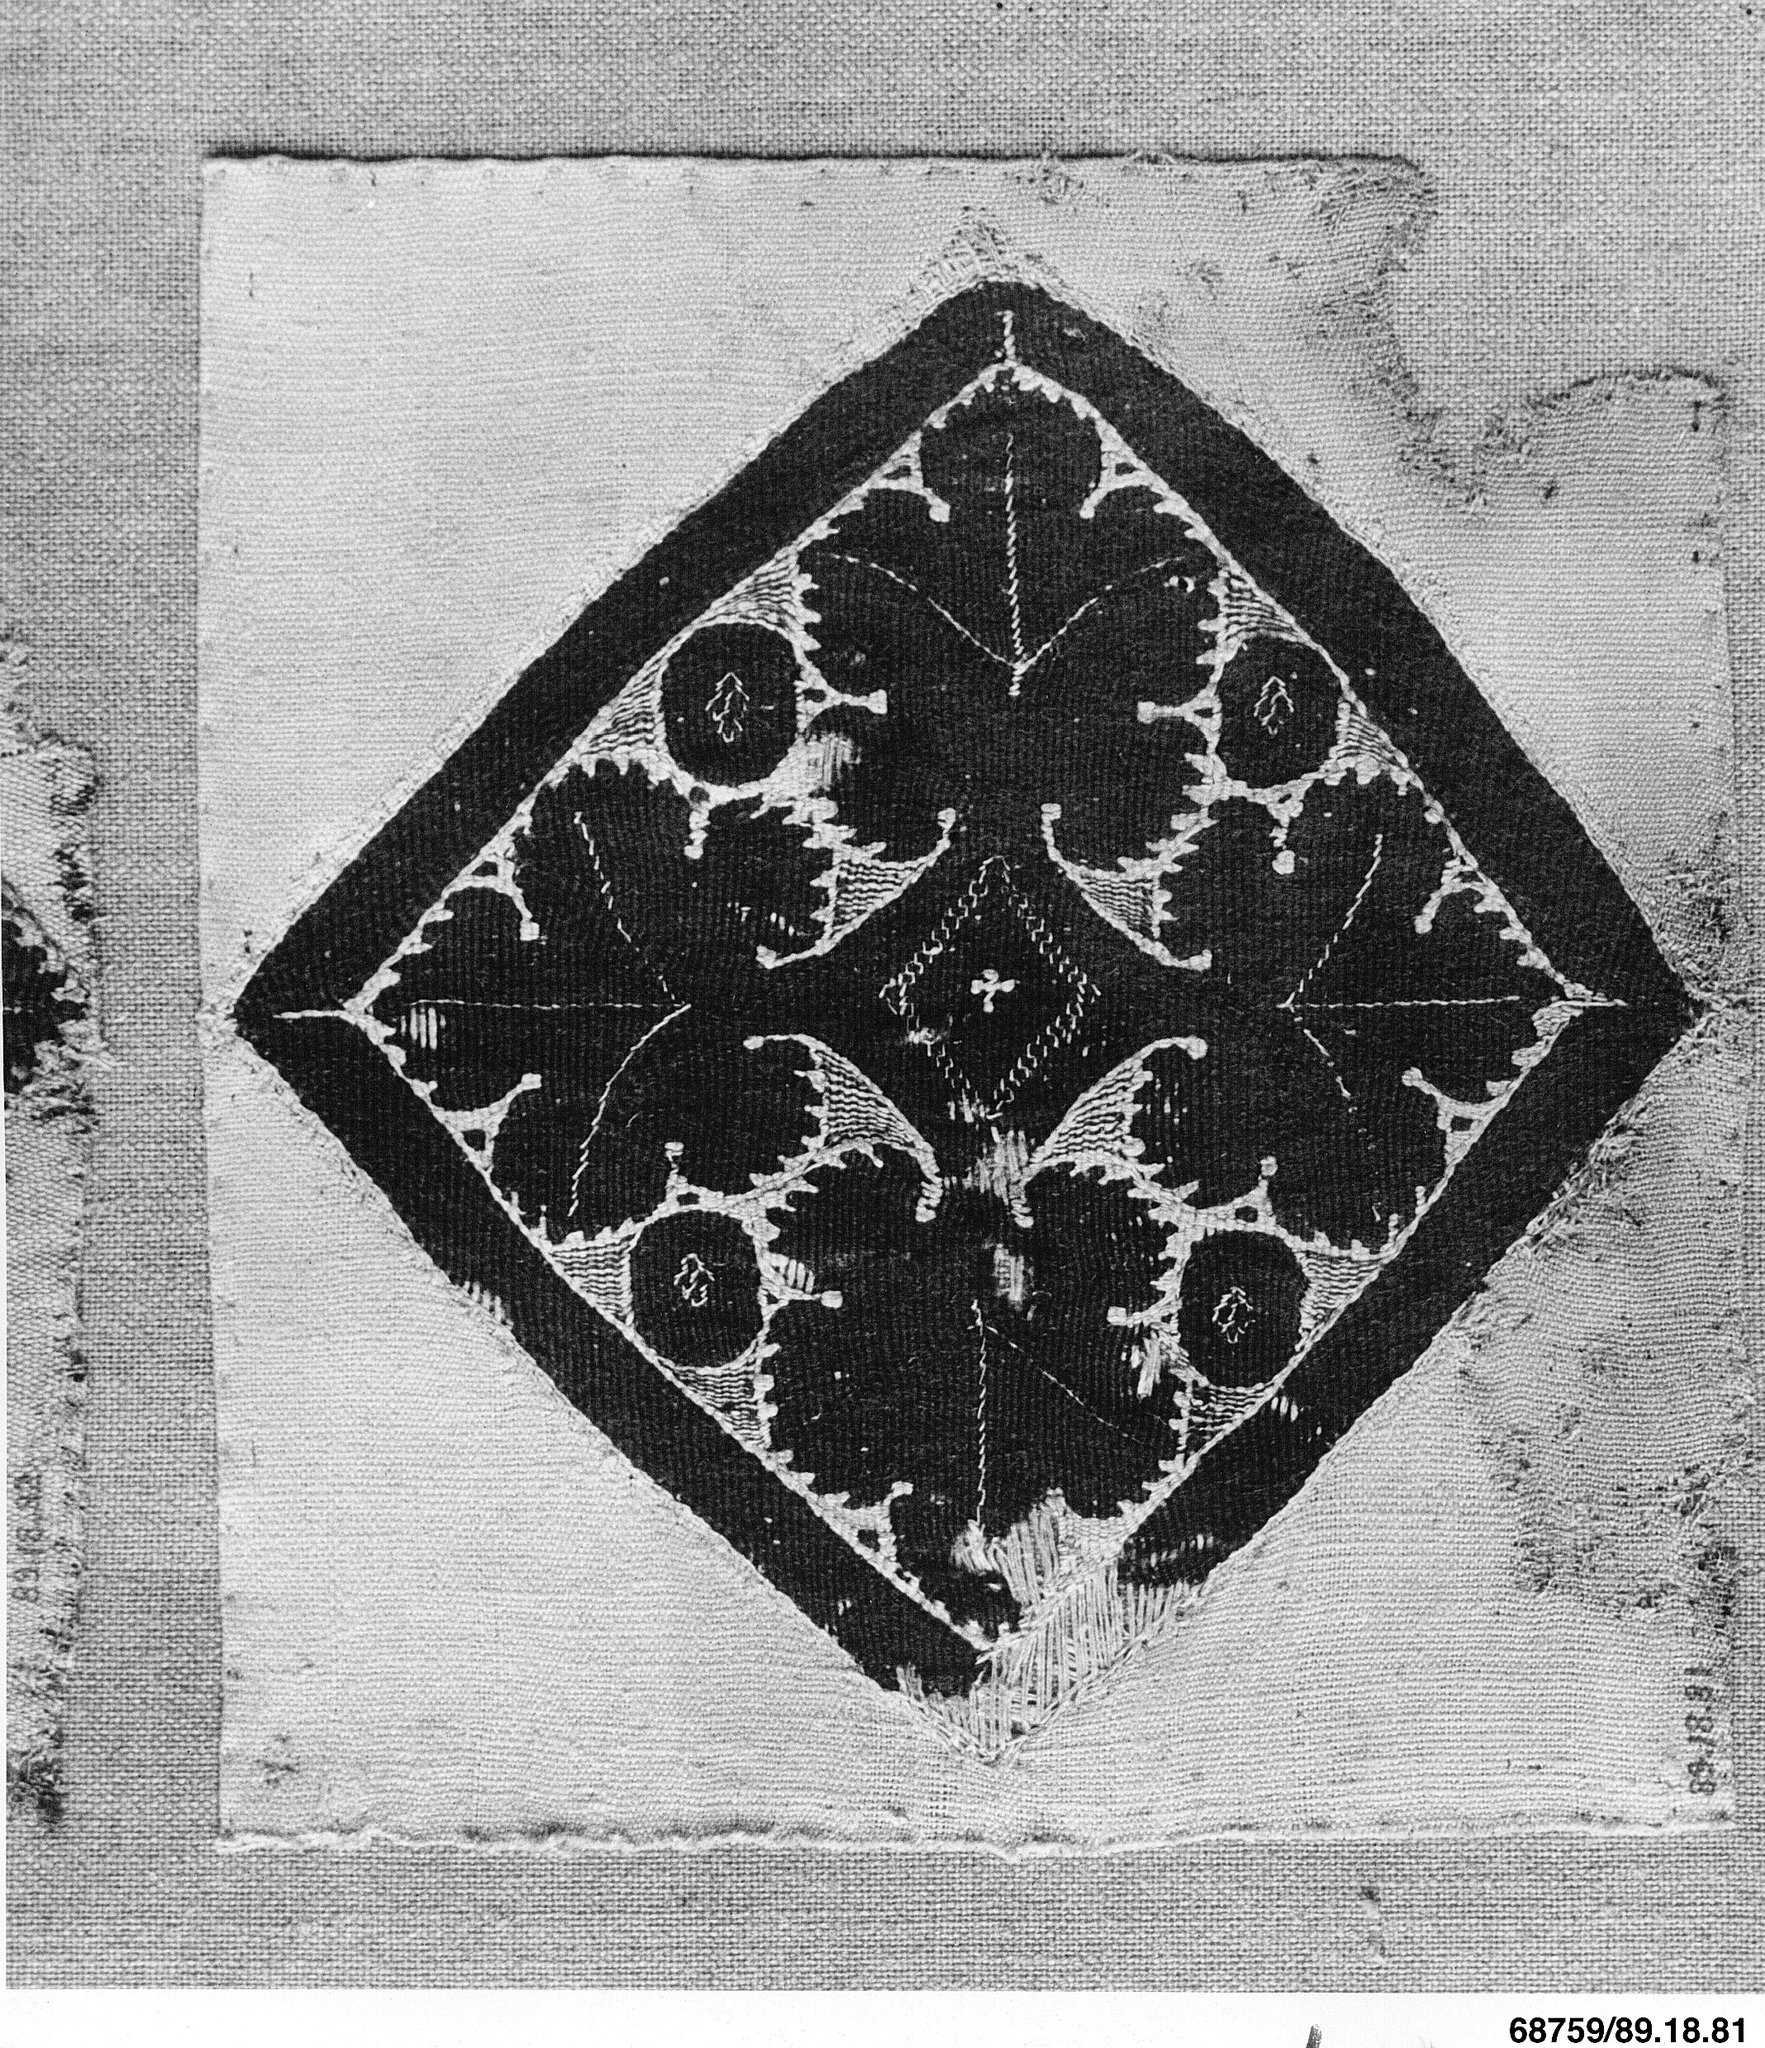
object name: textile fragment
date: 301-400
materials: linen, wool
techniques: weave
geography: egypt